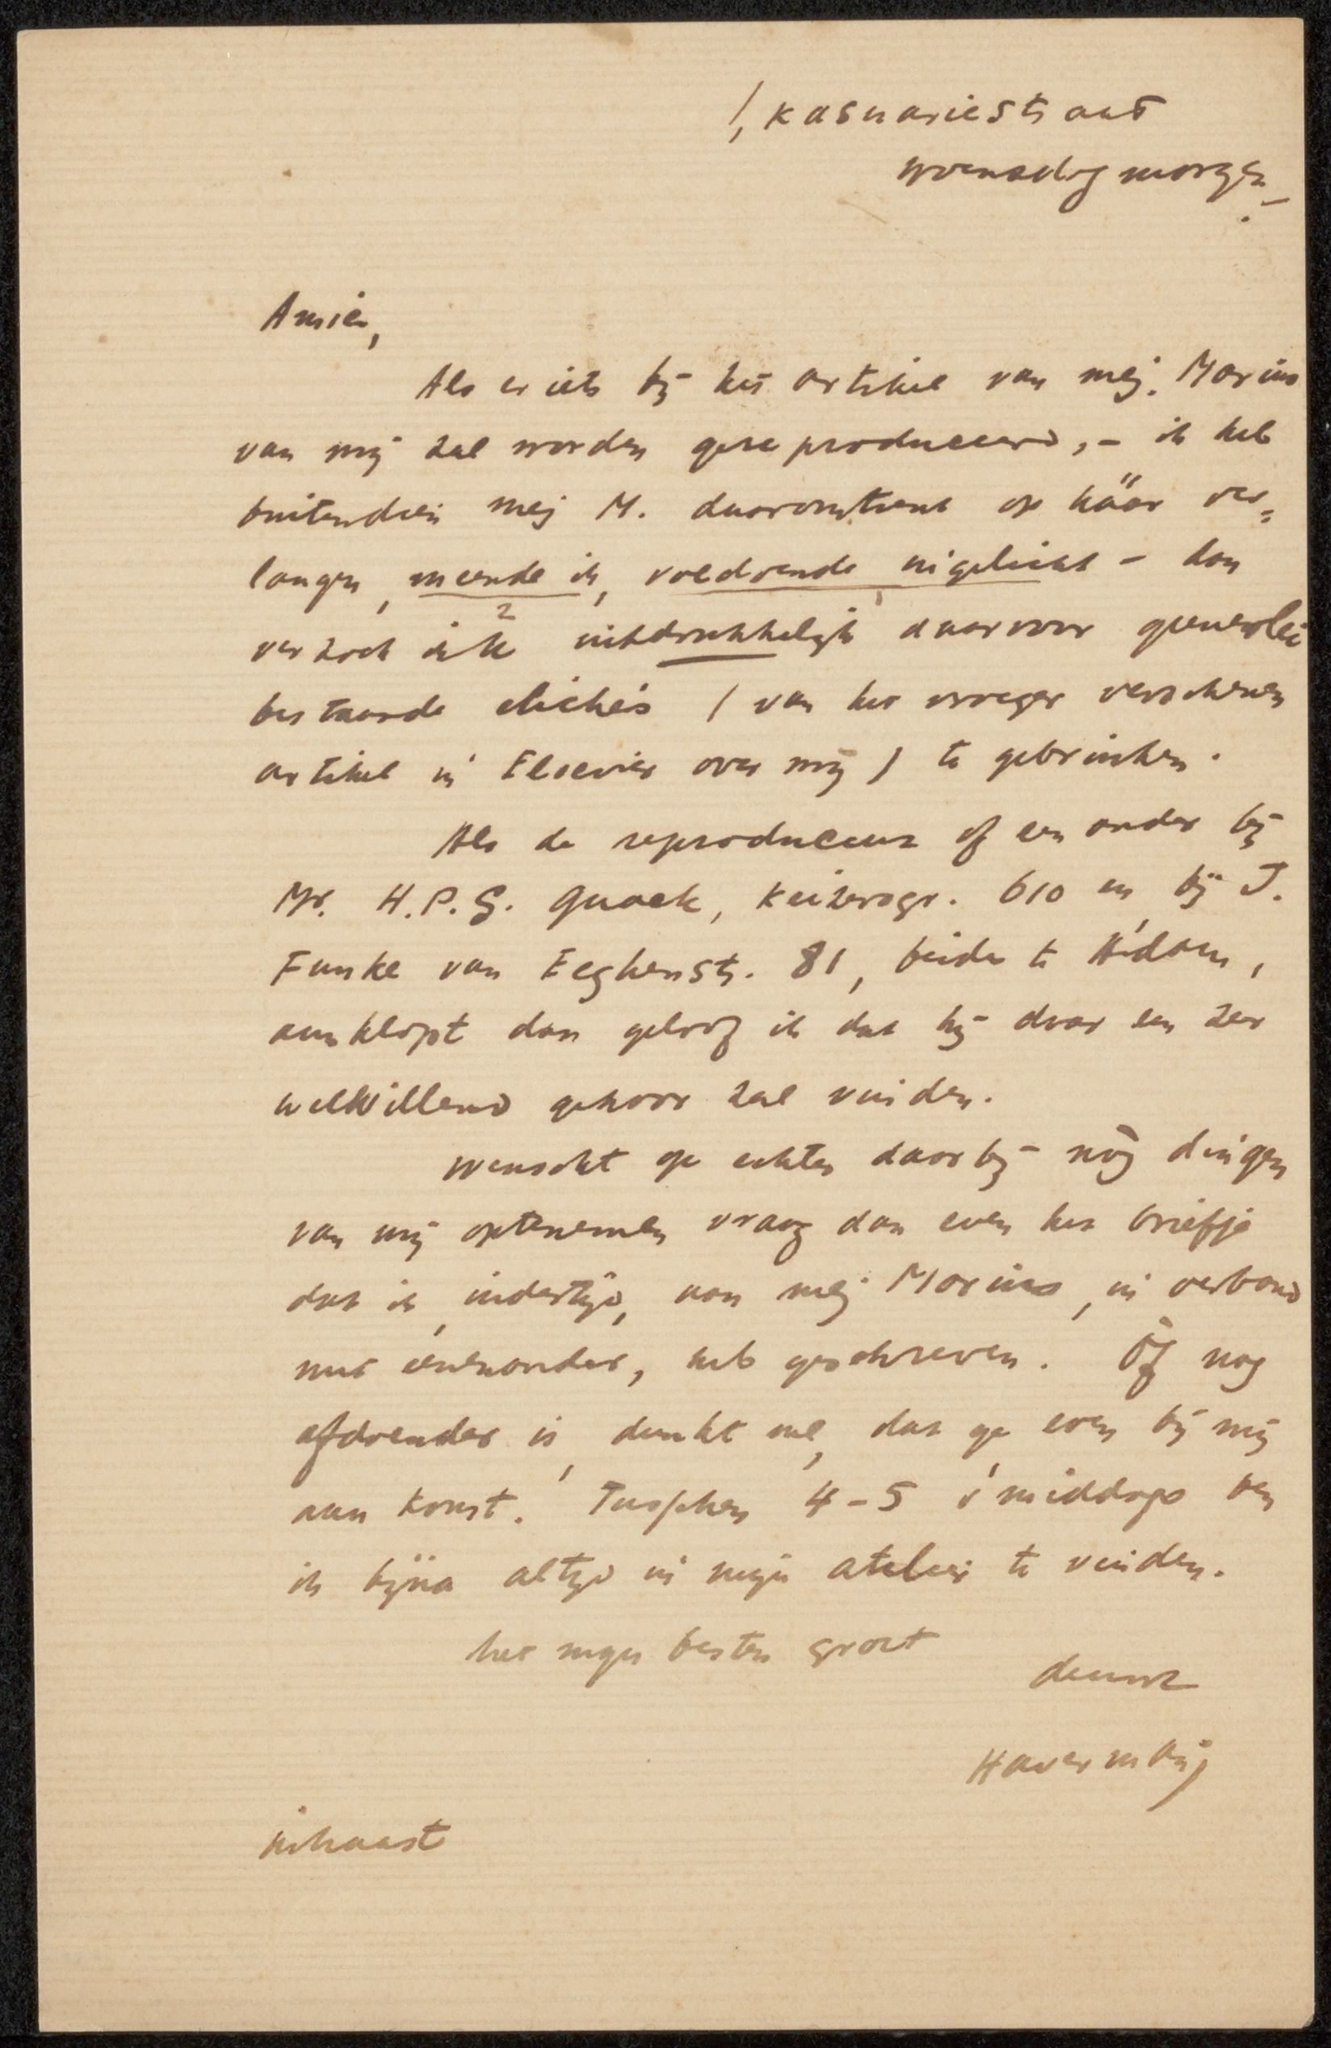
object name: letter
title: Brief aan Philip Zilcken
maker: hendrik johannes haverman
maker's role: draughtsman, print maker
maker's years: 1857-1928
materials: ink, paper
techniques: pen, writing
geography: the hague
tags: hendrick peter godfried quack, grada hermina marius, draughtsman, philip zilcken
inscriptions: collector's mark: ‘RPK’